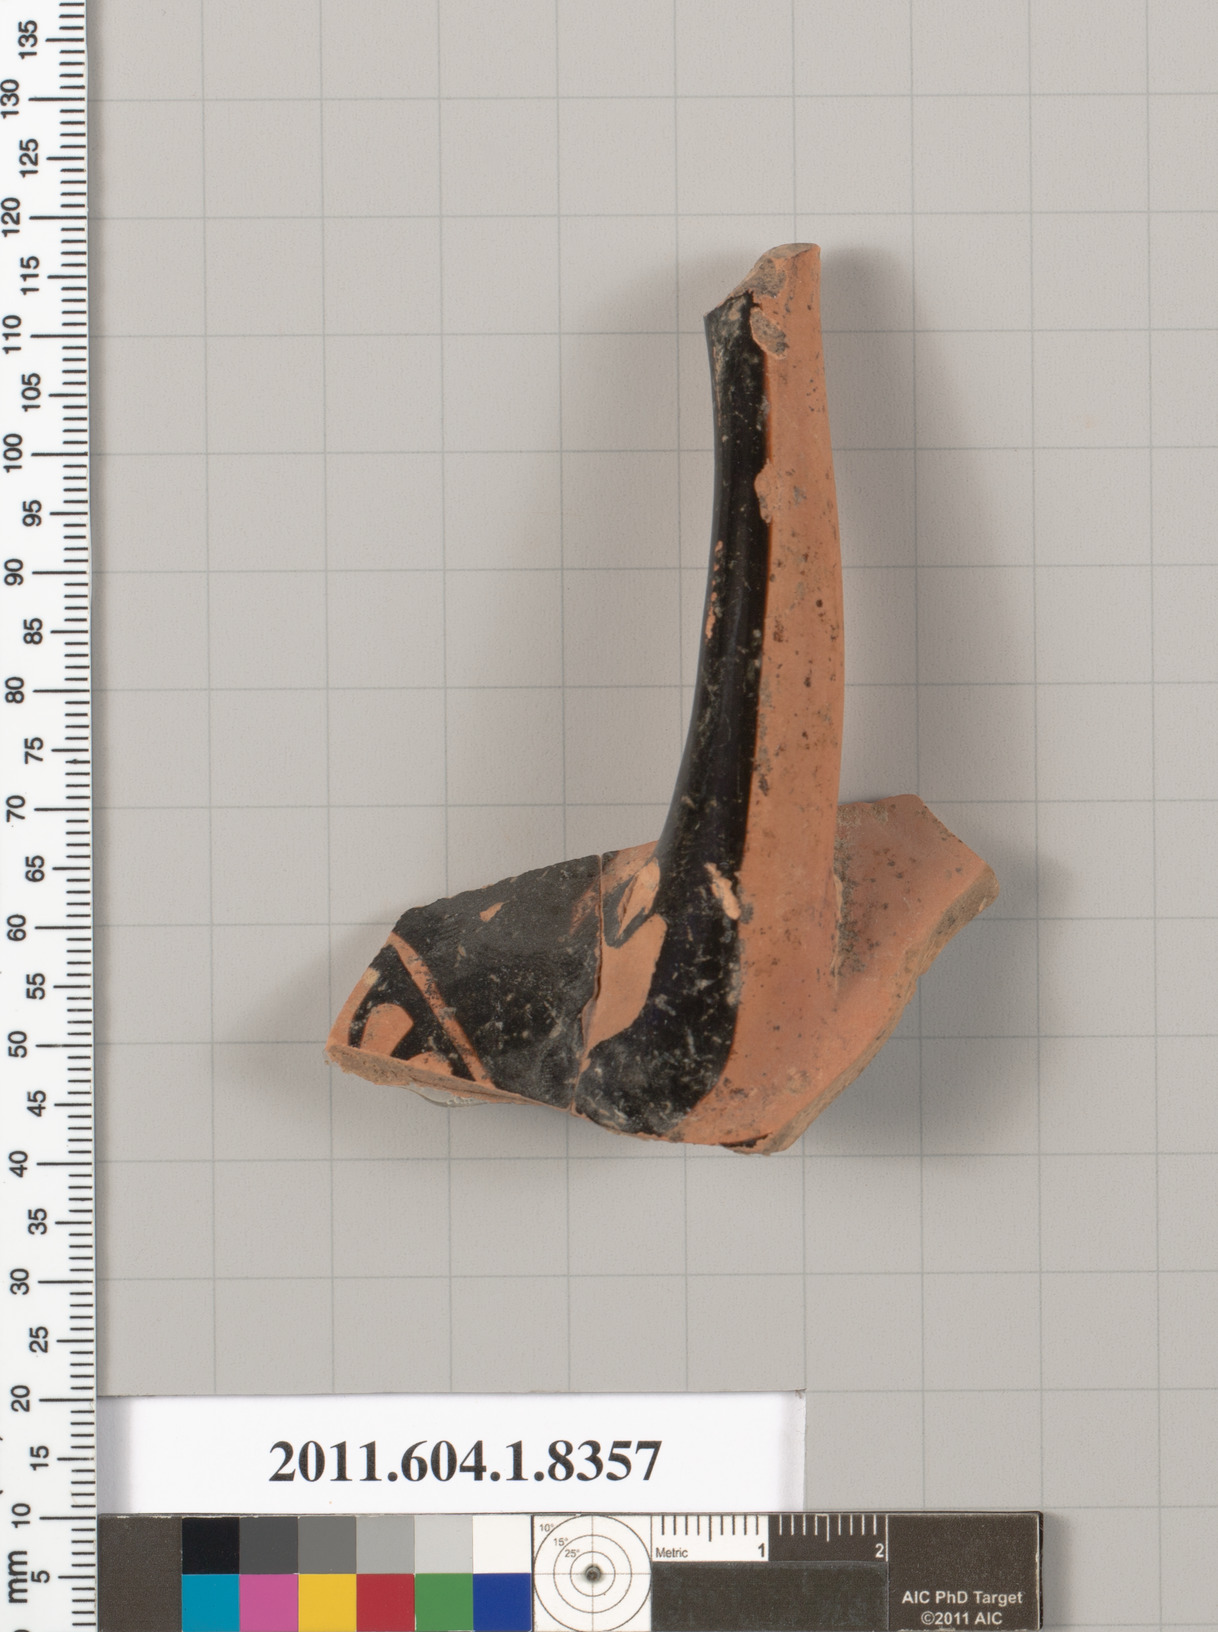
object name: kylix fragment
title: Terracotta fragment of a kylix (drinking cup)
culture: greek, attic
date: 400-376 BCE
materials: terracotta